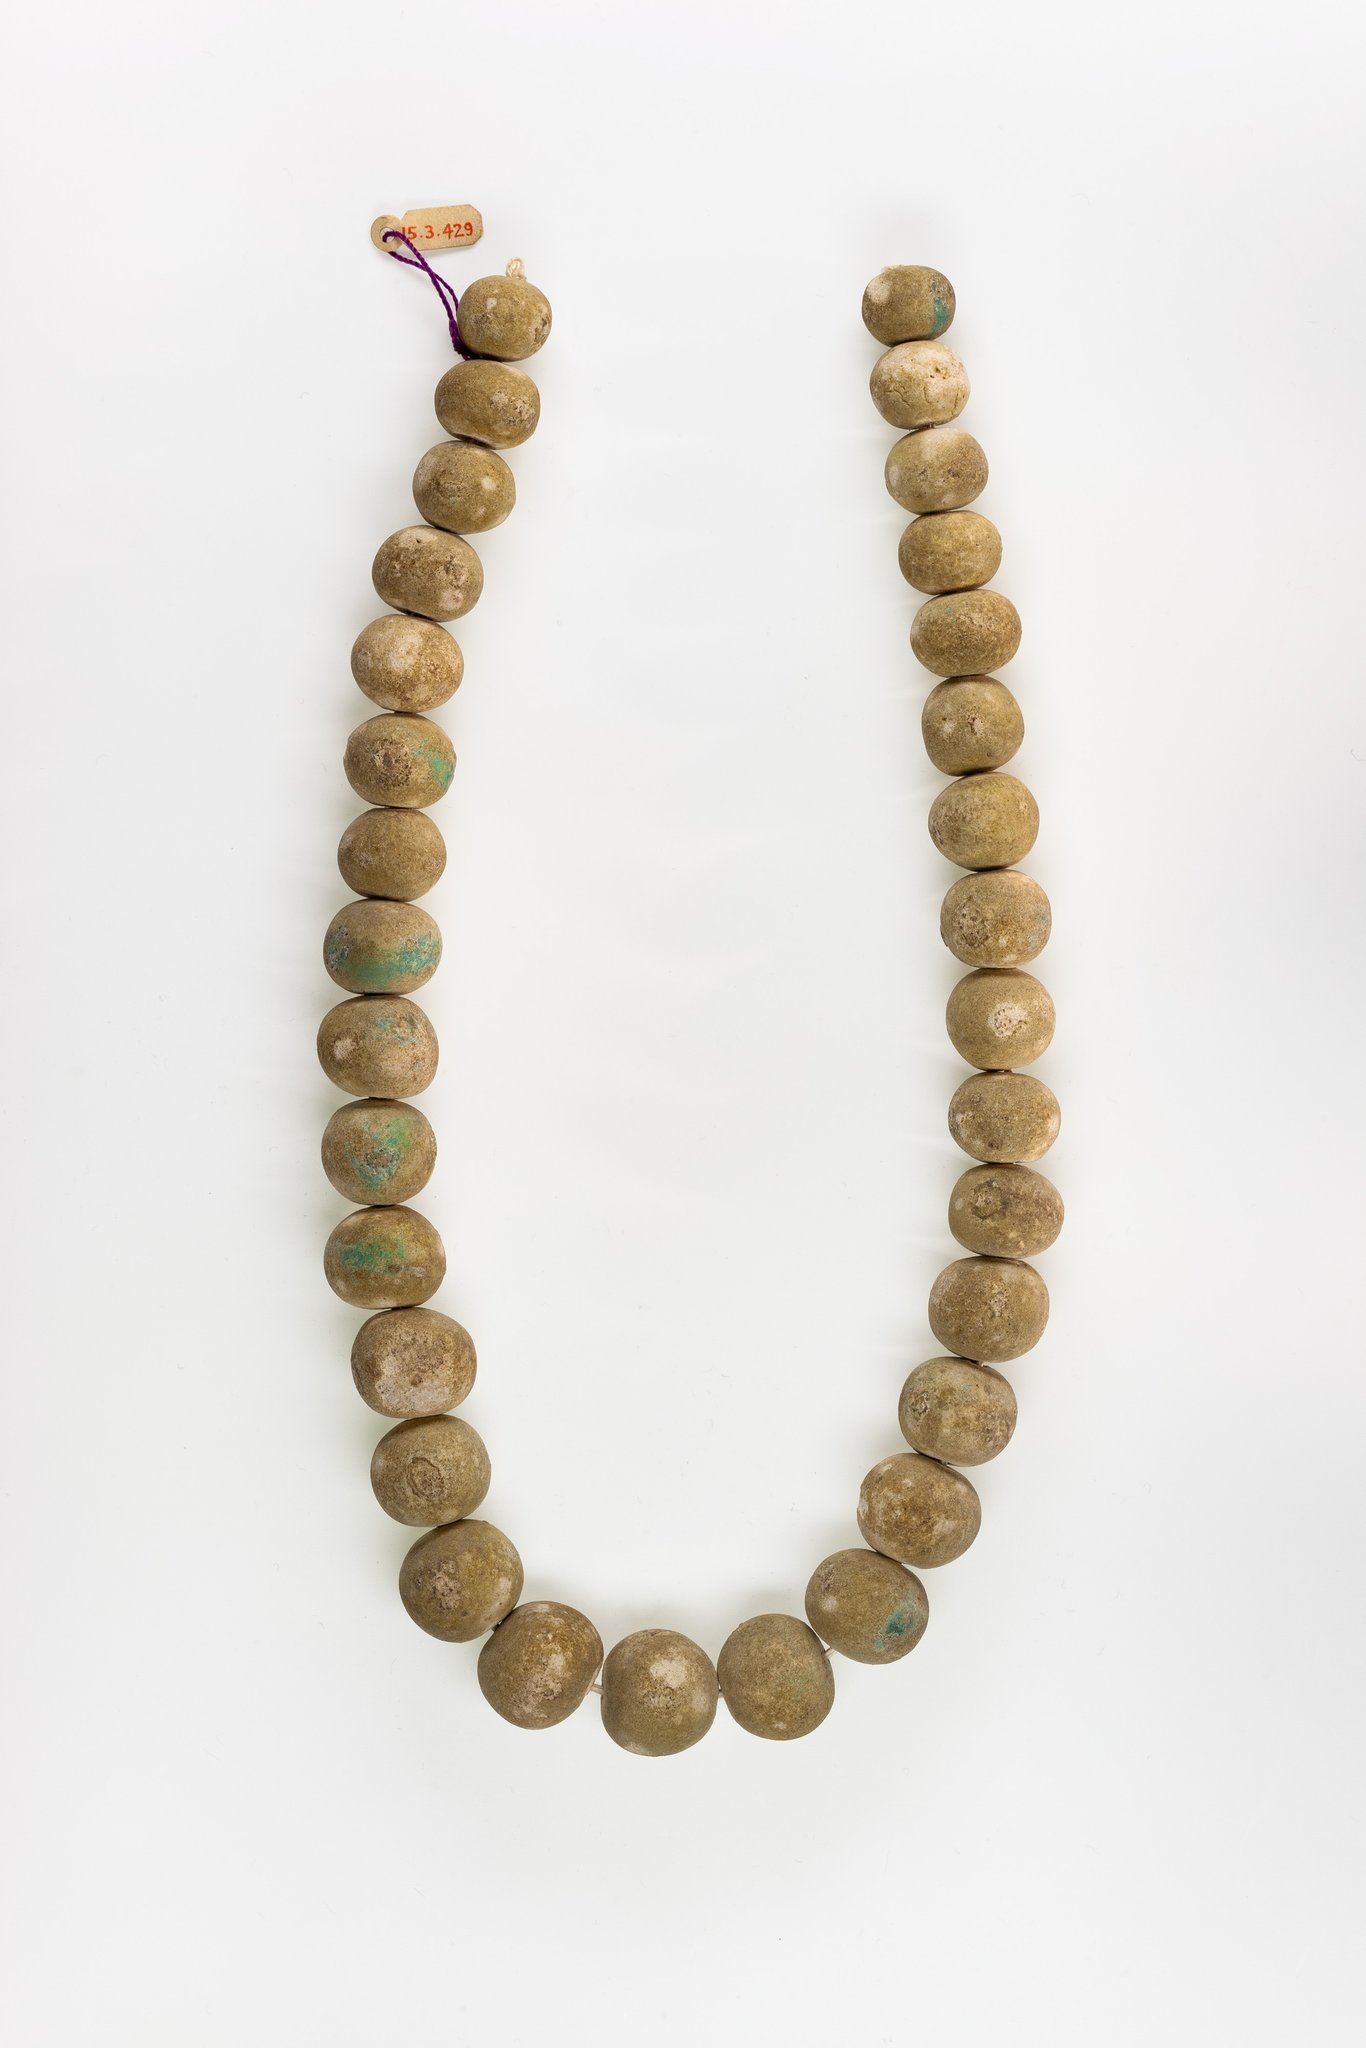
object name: bead, string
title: Necklace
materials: faience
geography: egypt